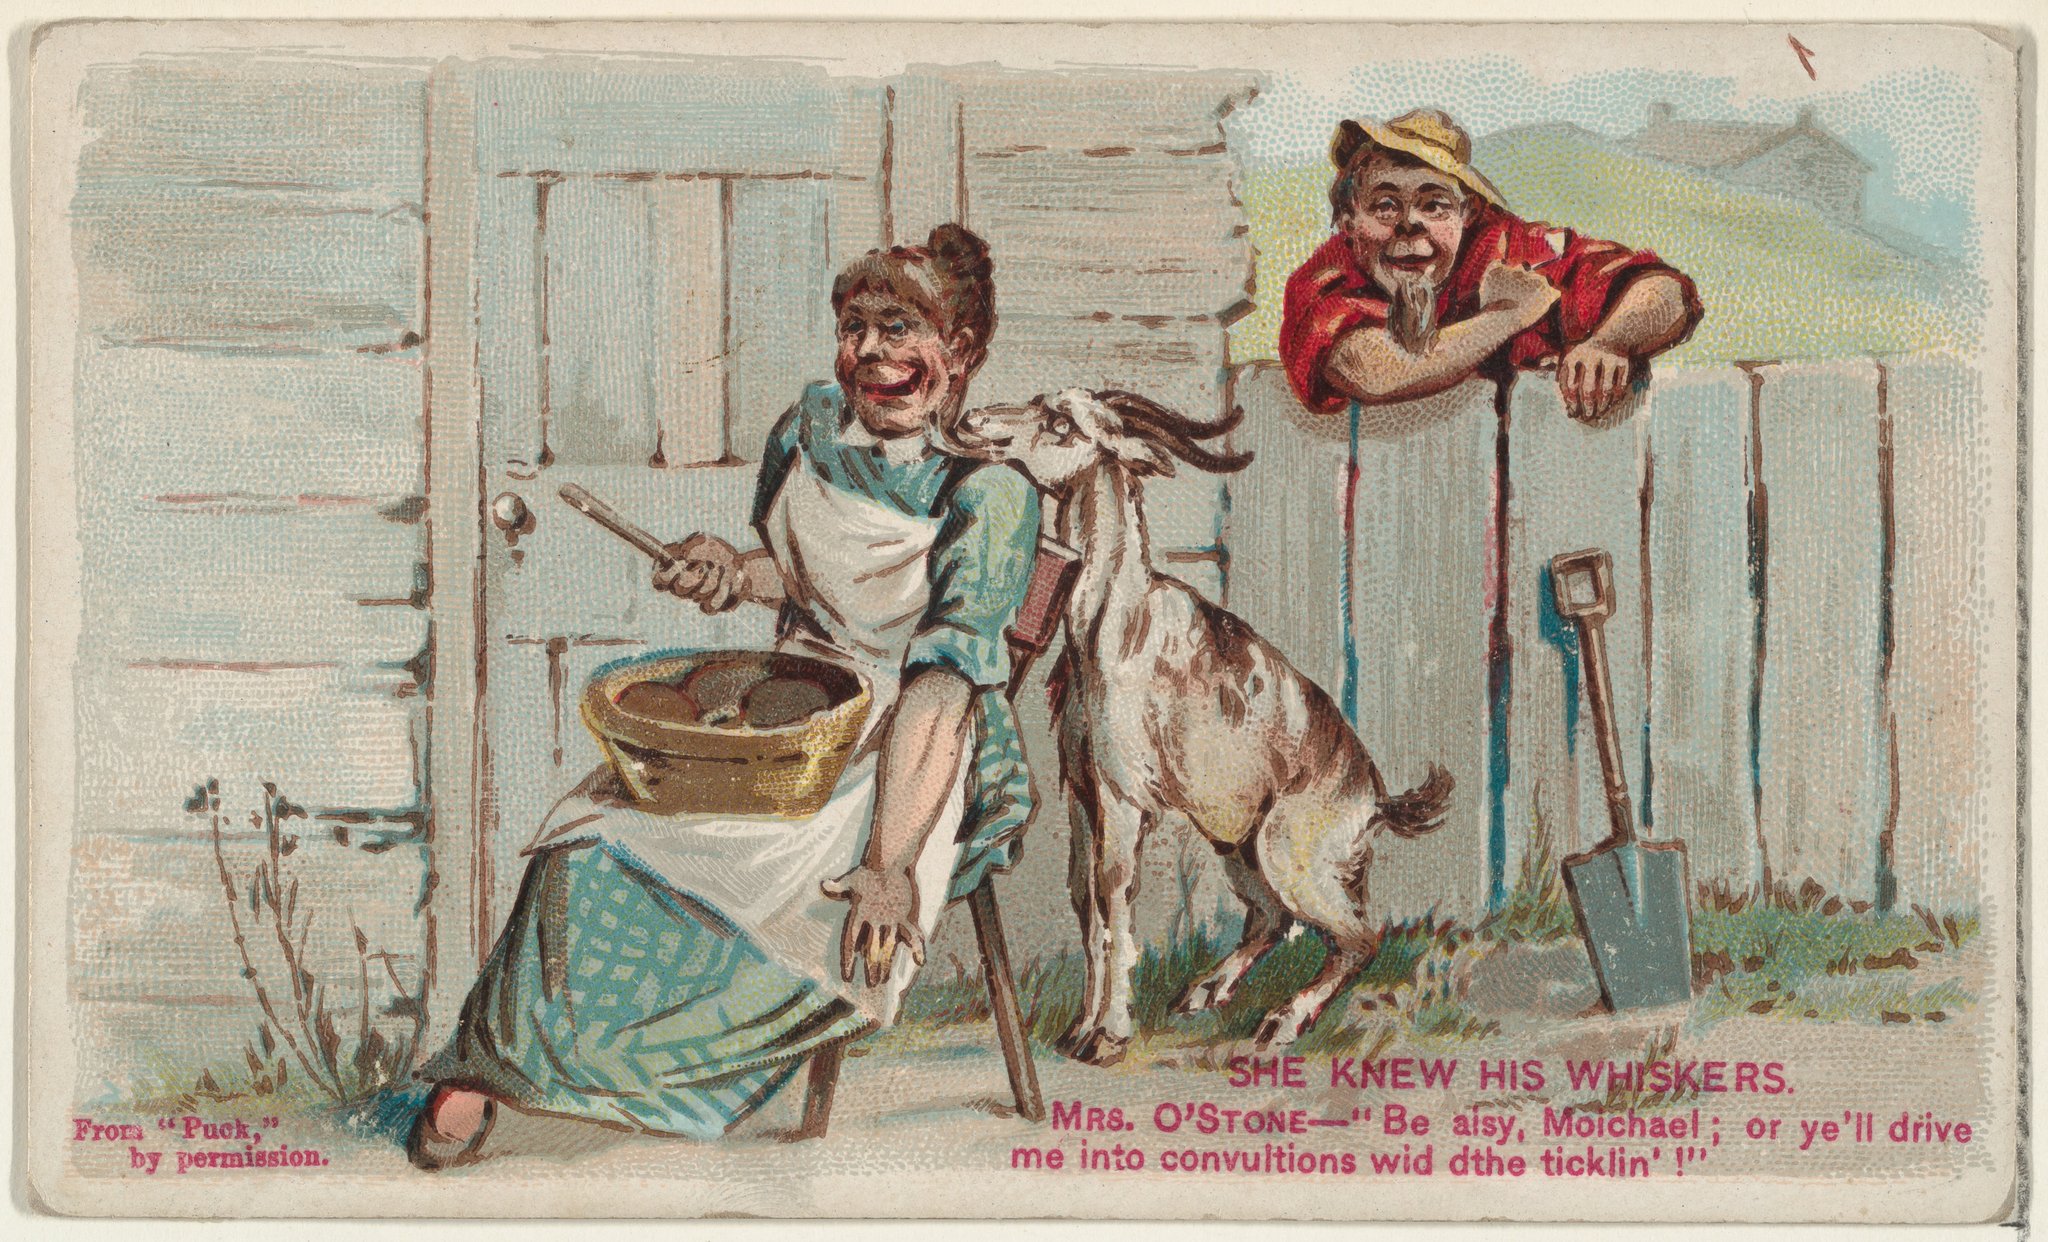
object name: print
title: She Knew His Whiskers, from the Snapshots from "Puck" series (N128) issued by Duke Sons & Co. to promote Honest Long Cut Tobacco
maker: w. duke, sons & co.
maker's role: publisher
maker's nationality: american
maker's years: 1870-1920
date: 1888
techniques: color lithograph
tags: men,women,goats,working